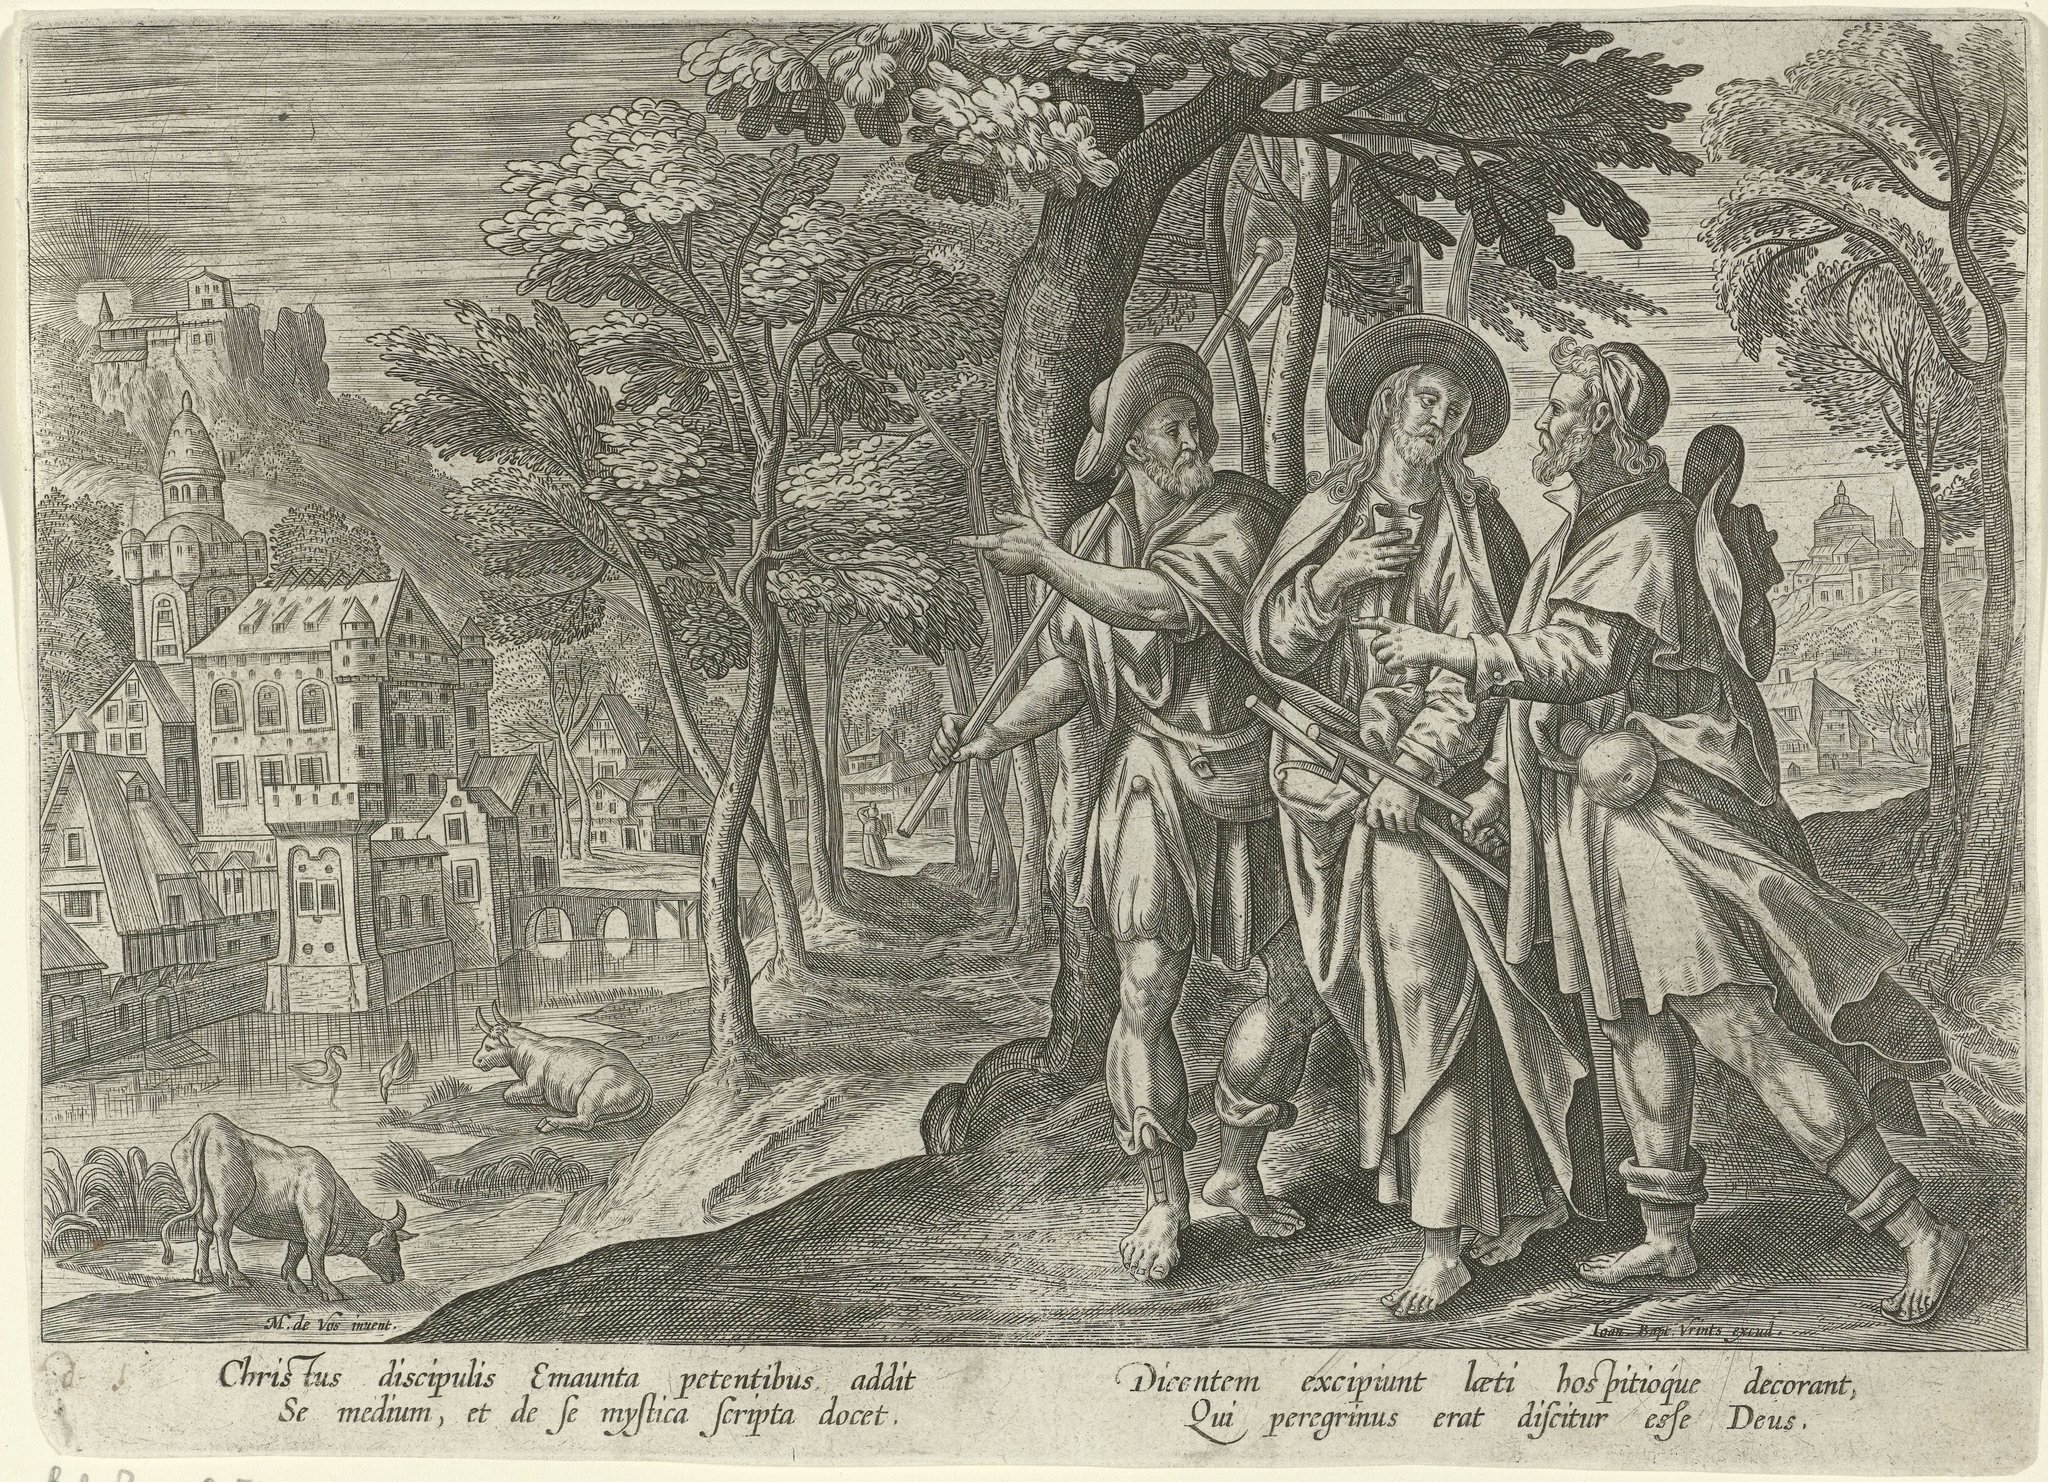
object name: print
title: Verschijningen van Christus na zijn dood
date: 1583-1585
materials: paper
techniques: engraving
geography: antwerp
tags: landscape with tower or castle, cleopas and peter meet christ (sometimes they are dressed as pilgrims)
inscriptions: collector's mark: Lugt 2228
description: Christus, gekleed als pelgrim, vergezelt twee apostelen op weg naar Emmaüs. Op de achtergrond een kasteel. De prent heeft een Latijns onderschrift en maakt deel uit van een serie van prenten met als onderwerp de verschijningen van Christus na zijn dood.